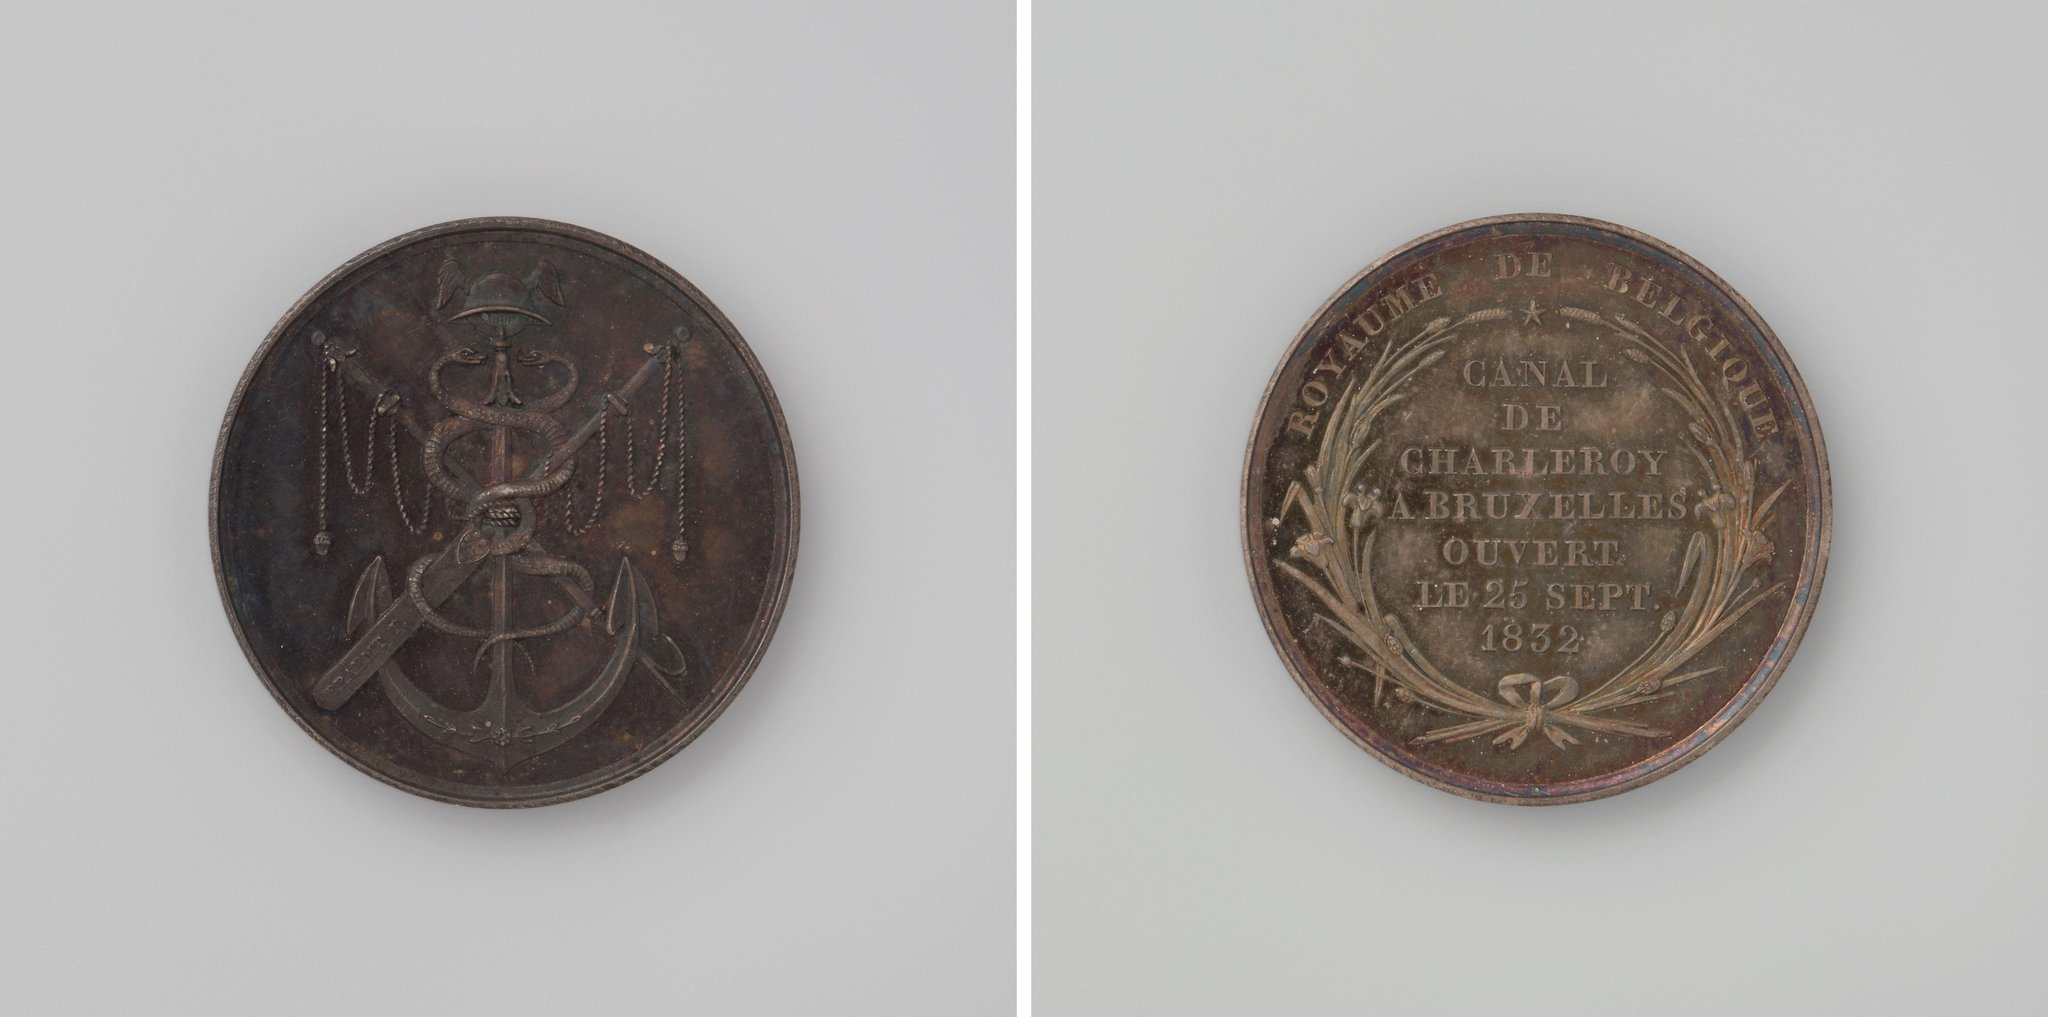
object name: history medal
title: Opening van het kanaal van Charleroi naar Brussel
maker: joseph pierre braemt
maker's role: print maker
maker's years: 1796-1864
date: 1832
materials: silver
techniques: striking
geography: brussels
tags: kanaal charleroi-brussel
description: Zilveren penning. Voorzijde: Mercuriusstaf op anker, daarachter gekruist roer en harpoen. Keerzijde: opschrift binnen bloemenkrans en omschrift